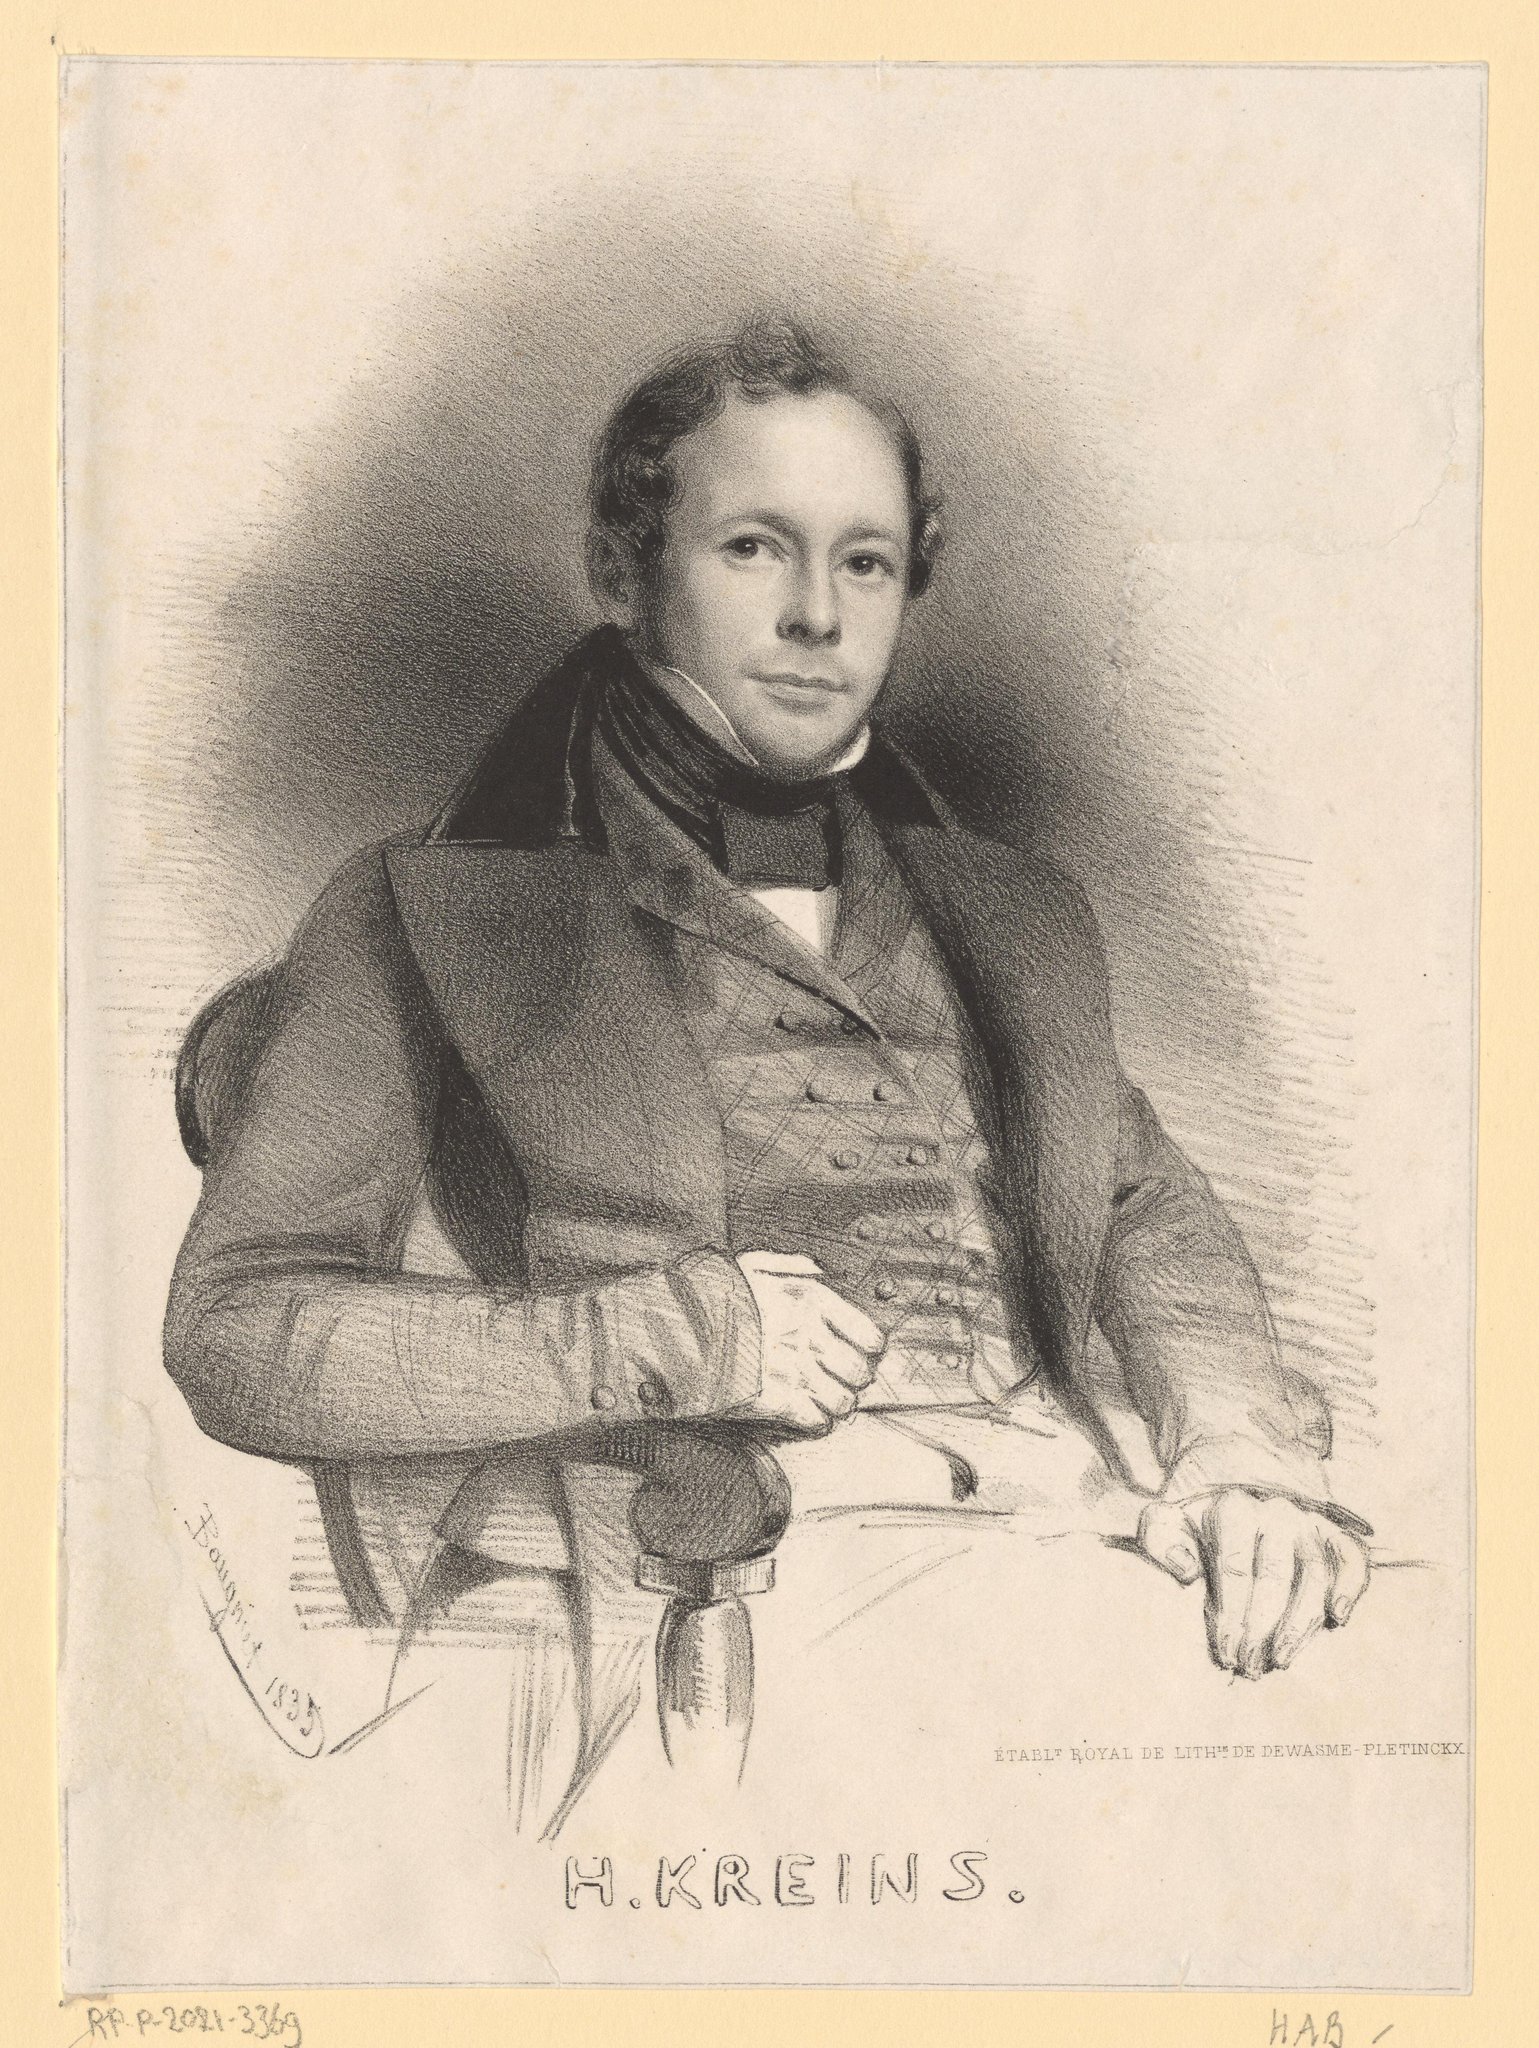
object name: print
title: Portret van Hilaire Antoine Kreins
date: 1835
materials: paper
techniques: lithograph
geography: brussels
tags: brussels, print maker, hilaire antoine kreins, sitting figure, historical persons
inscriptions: date